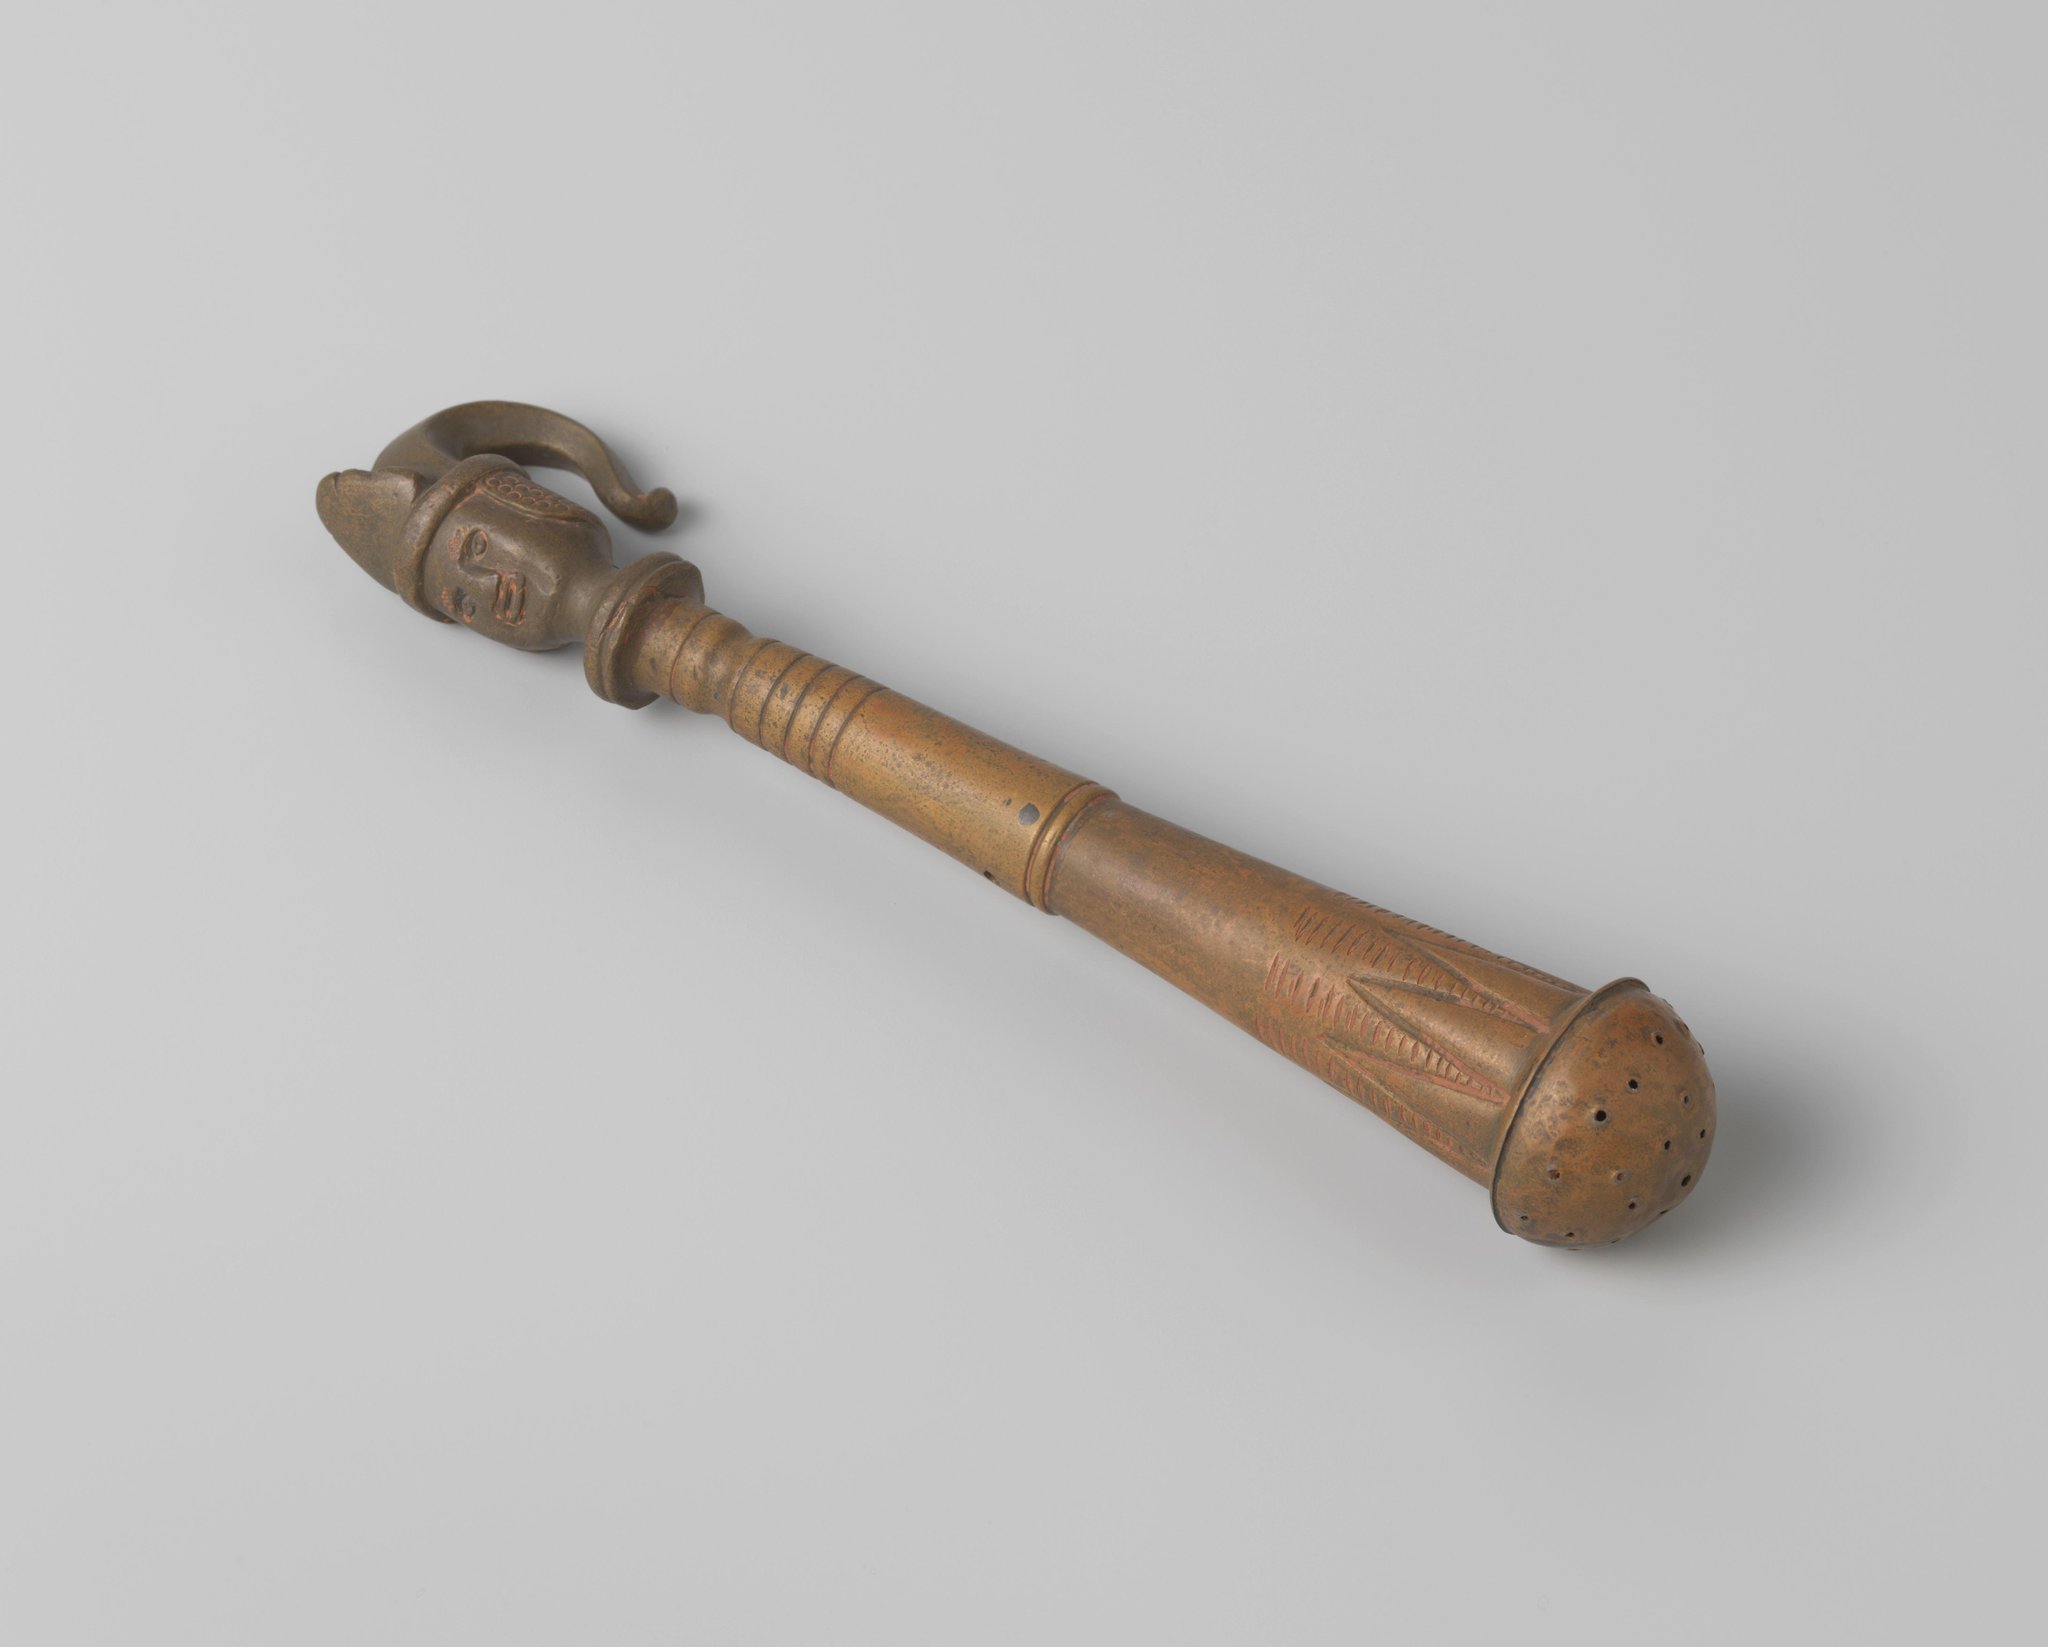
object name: sprenkelfles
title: Sprenkelaar of sprenkelfles met narrenkop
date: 1600-1699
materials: brass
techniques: casting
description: Het voorwerp is uit drie delen samengesteld: de gegoten in een narrekop eindigende haak, het middenstuk, dat onder van een gaatje is voorzien, en het onderste uit een plaat gemaakte holle gedeelte, dat door een geperforeerde bol wordt afgesloten.